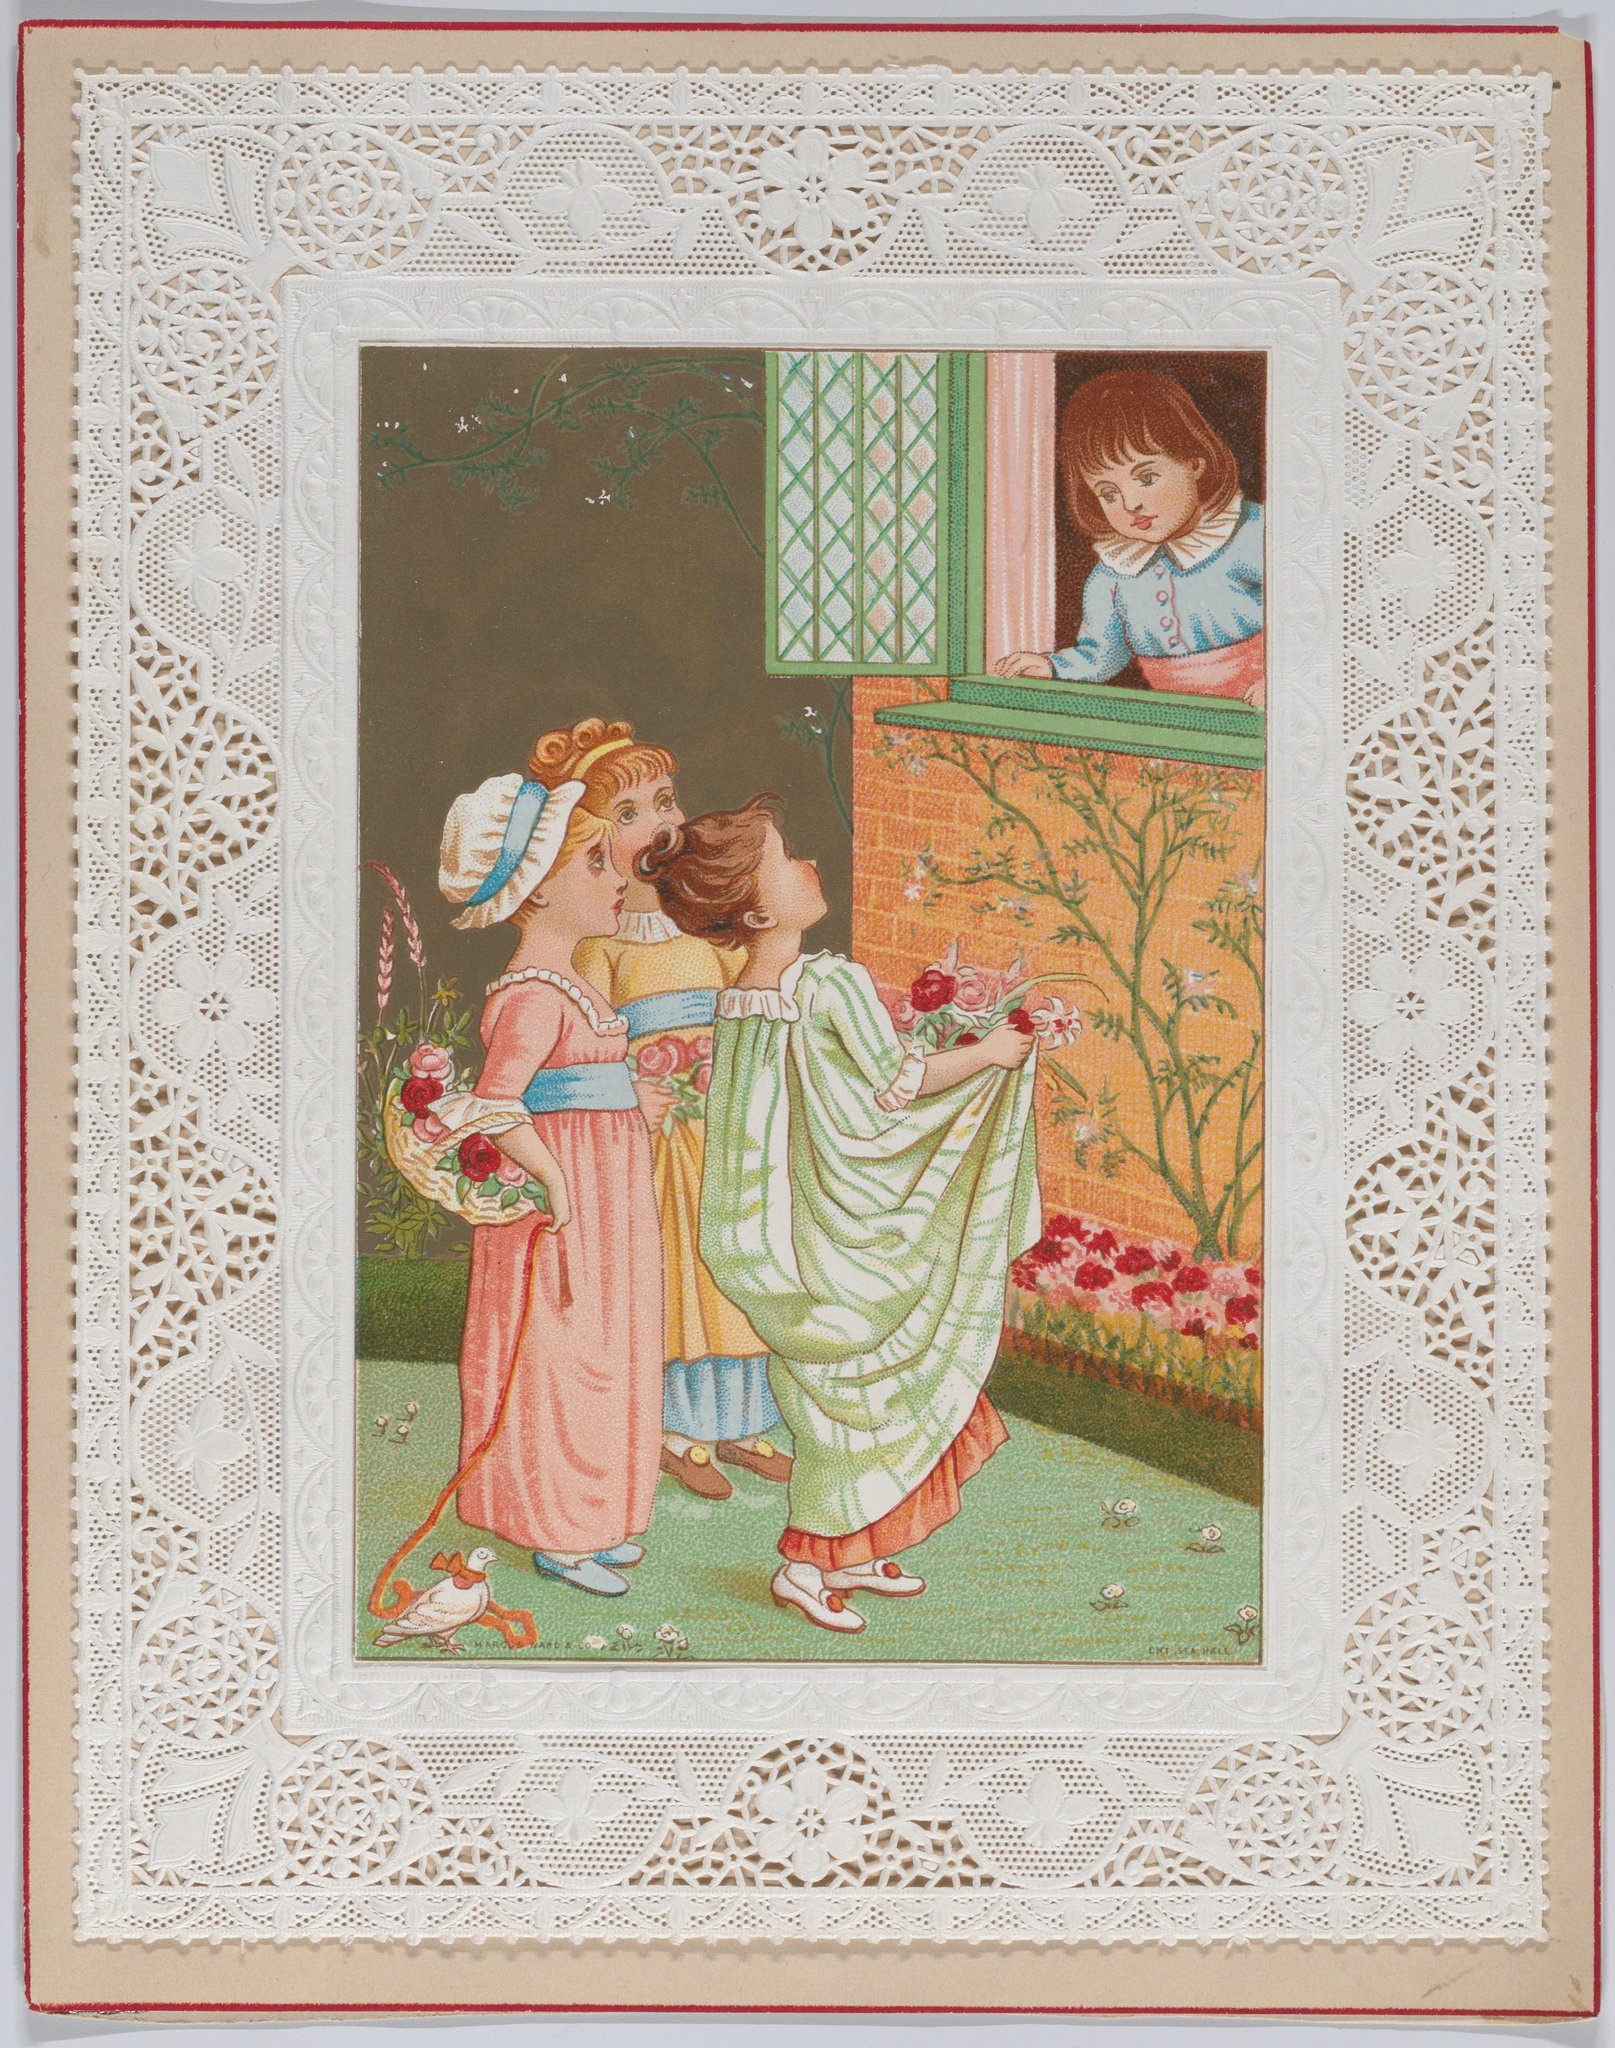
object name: valentine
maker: kate greenaway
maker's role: artist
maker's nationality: british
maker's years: 1846-1901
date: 1880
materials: gold, lace, paper, watercolor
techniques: chromolithography, embossing, gilding, lithograph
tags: boys,girls